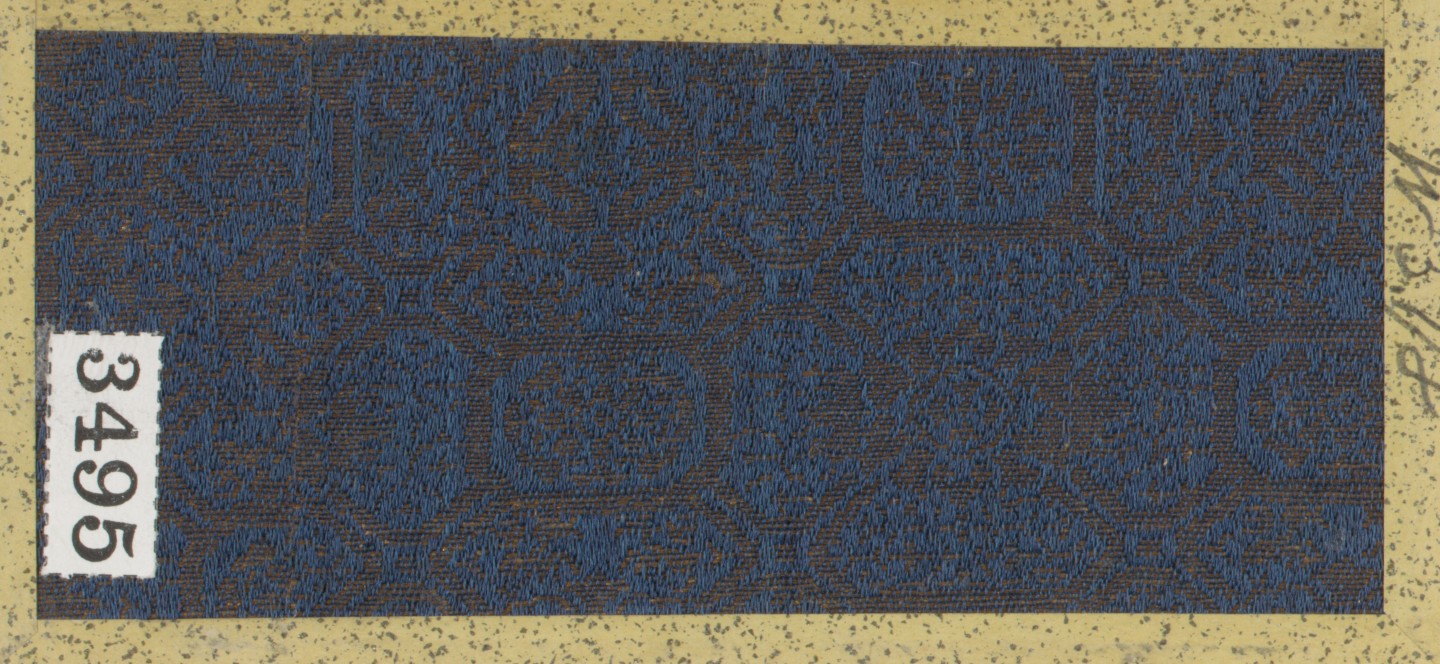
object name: sample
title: Textile Sample from Sample Book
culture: japanese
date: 1801-1900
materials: silk